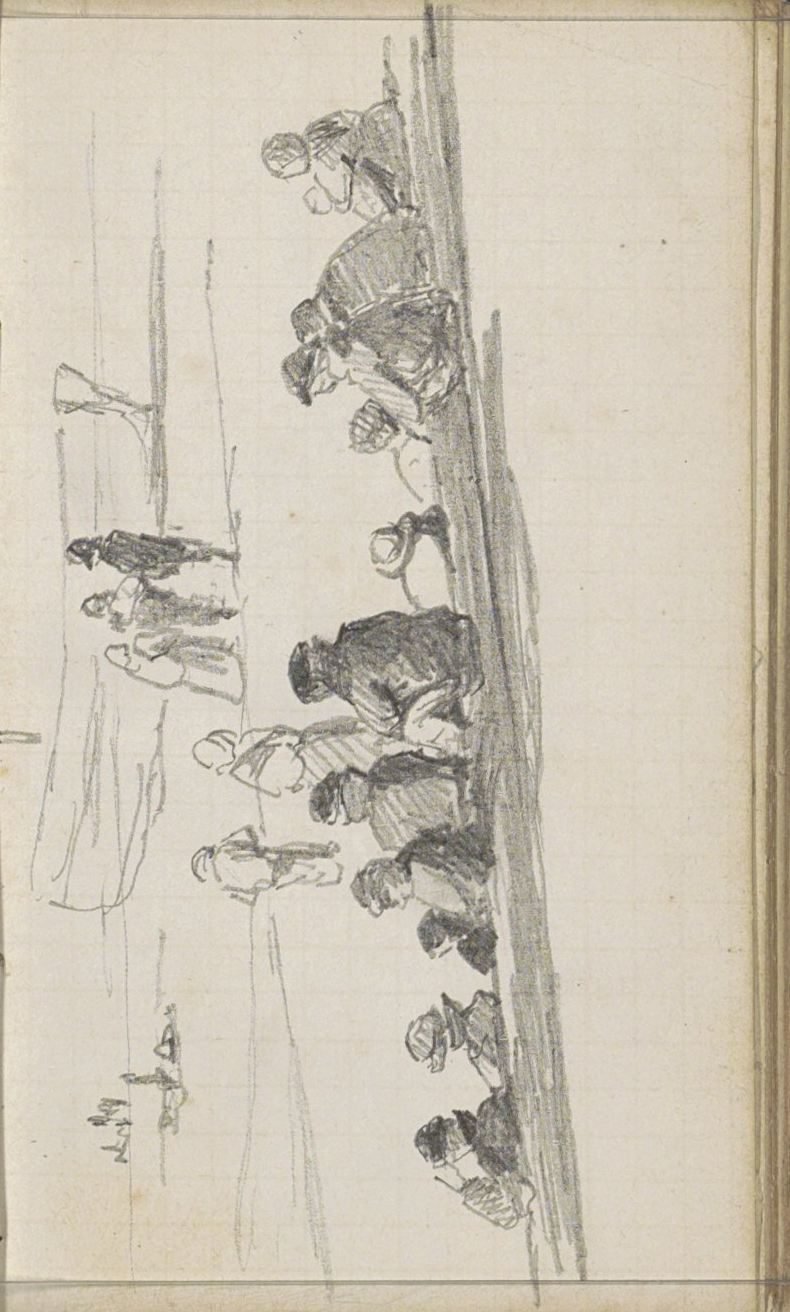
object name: sketchbook leaf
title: Zittende figuren aan een kade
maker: jan willem van borselen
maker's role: draughtsman, print maker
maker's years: 1825-1892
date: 1868-1887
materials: pencil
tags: landscapes (+ landscape with figures, staffage), quay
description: Blad 18 recto uit een schetsboek met 51 bladen.